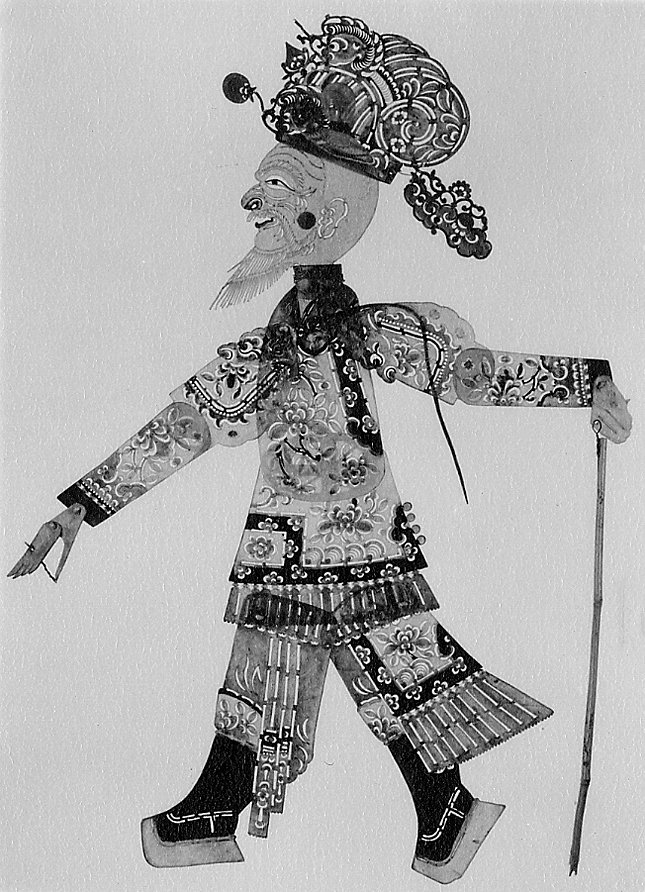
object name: shadow puppet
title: Military General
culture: chinese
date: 1801-1900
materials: bamboo, cotton, hair, hemp, metal, pigment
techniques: incising, painting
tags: swords,generals